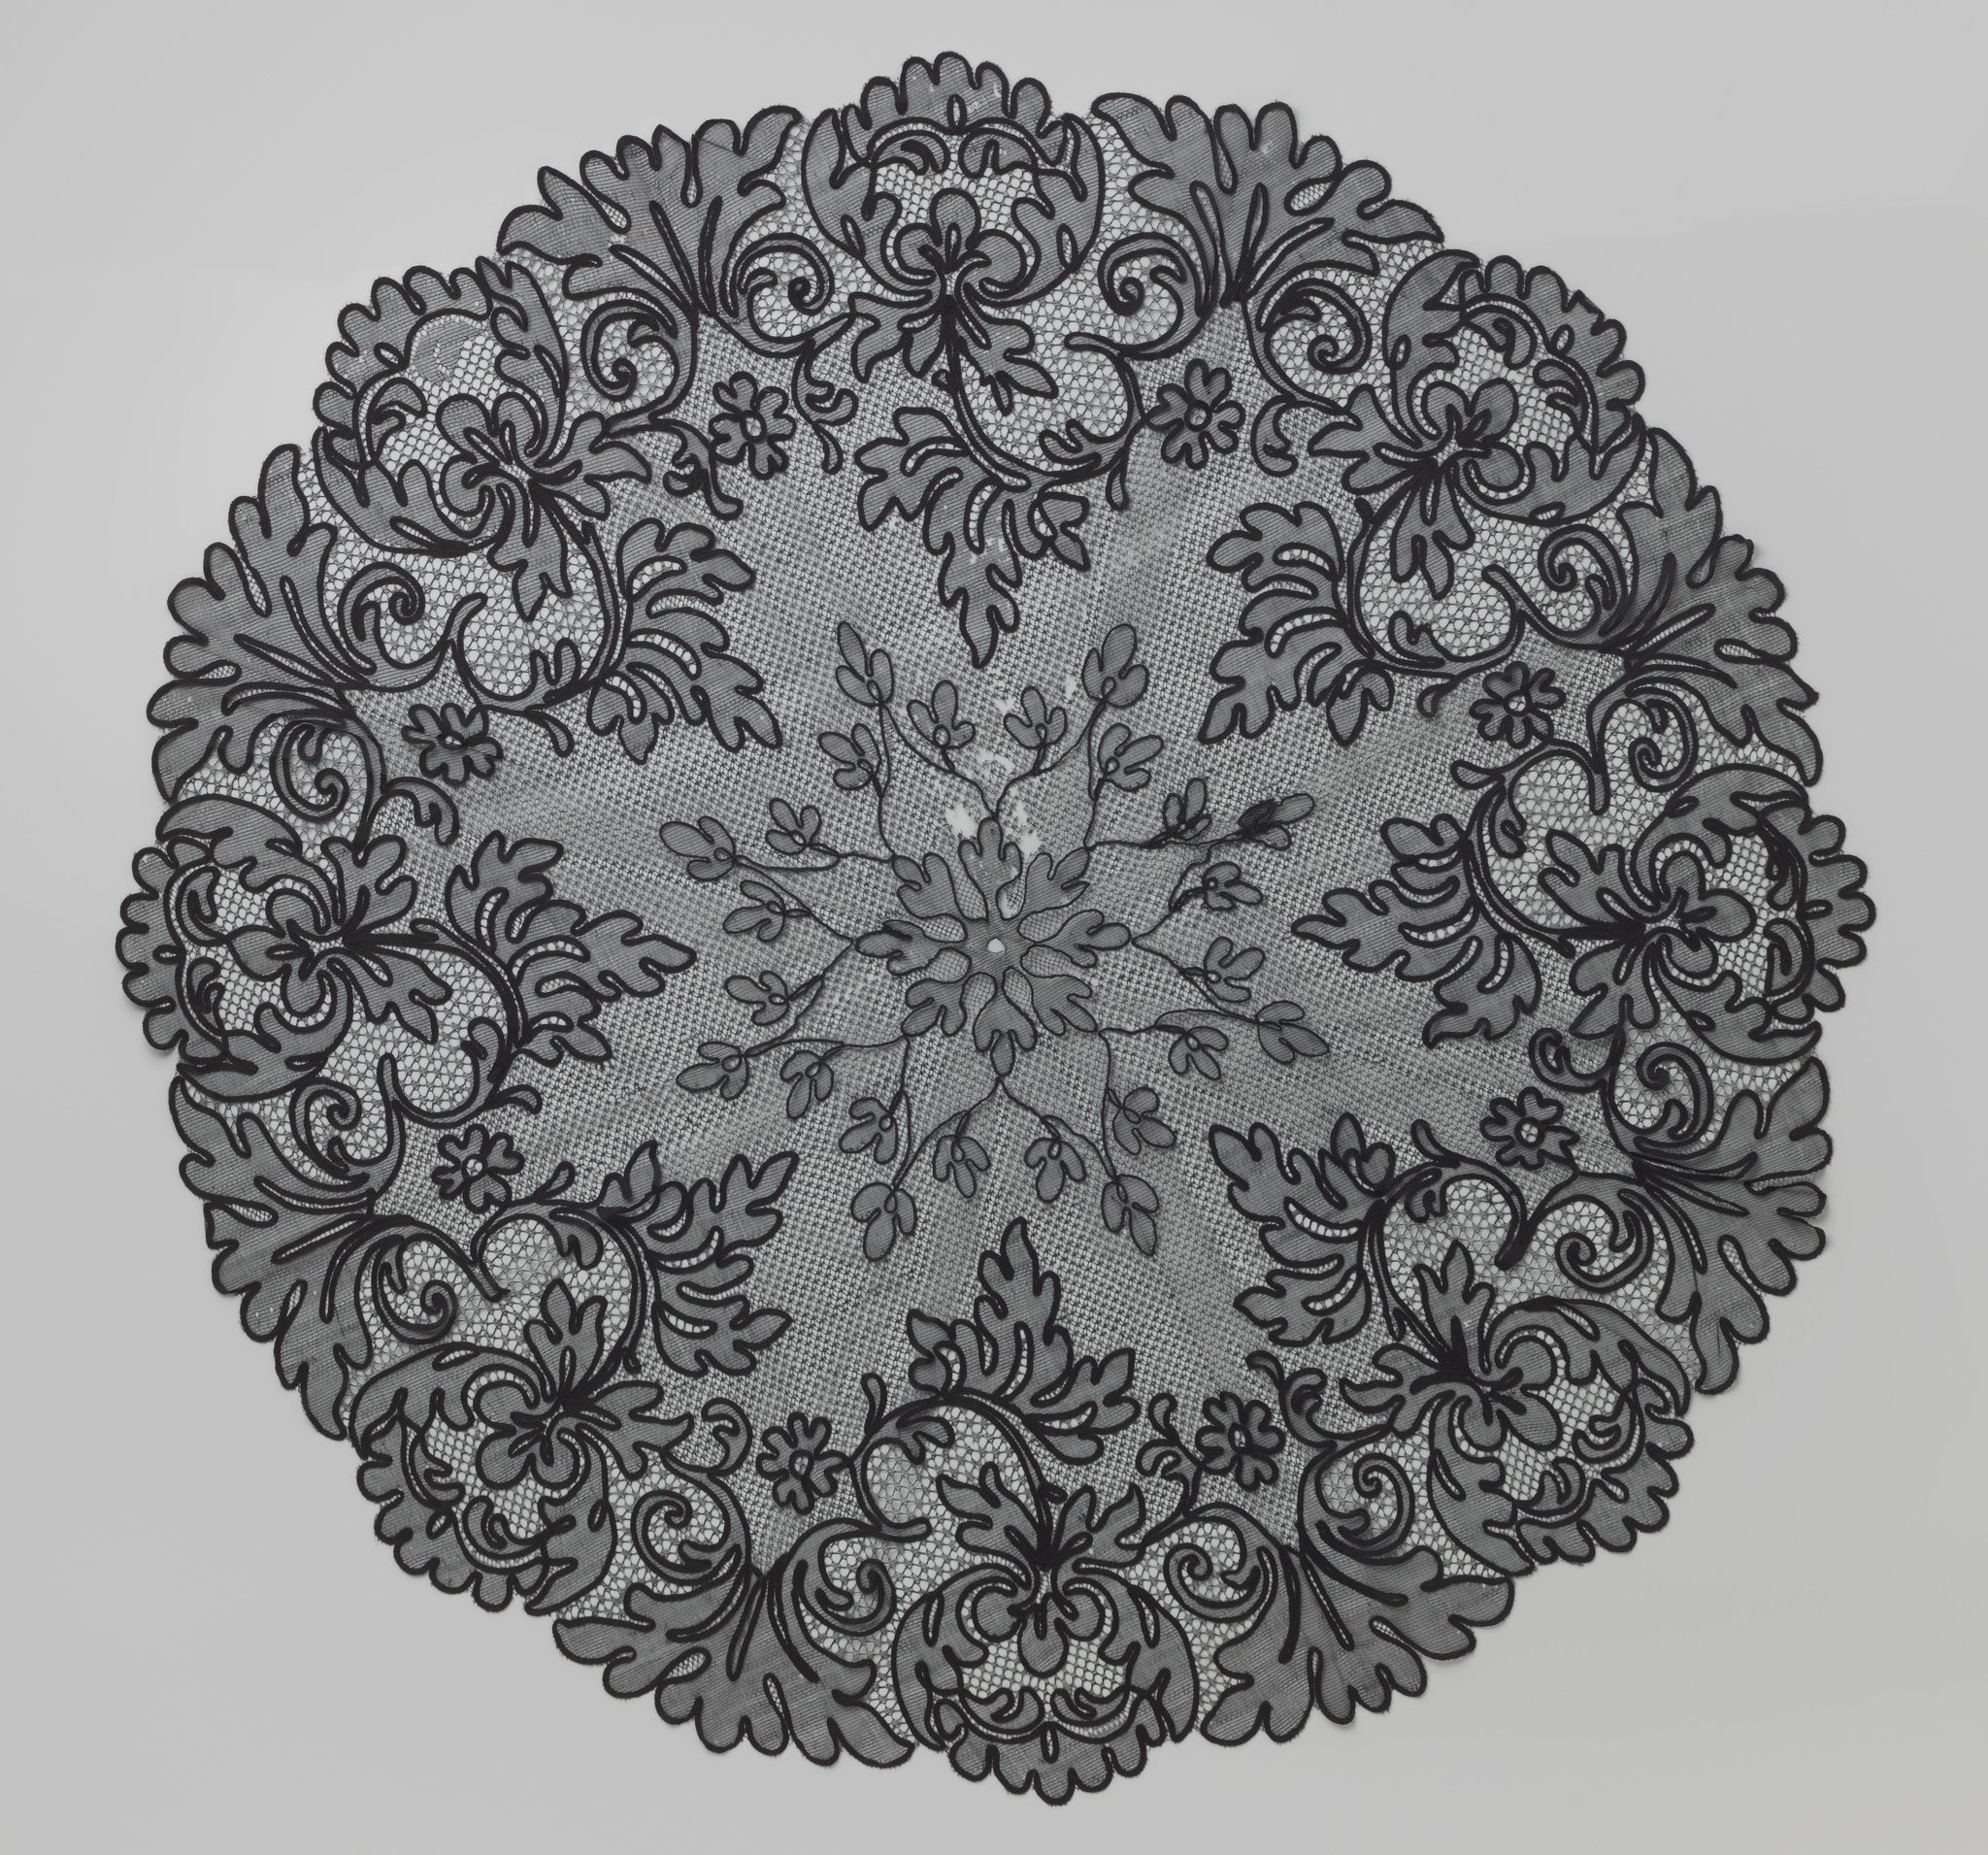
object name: womenswear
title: Parasoldek van zwart veterkant, versierd met een bloem en acht hangende bladpalmetten; de tussenruimtes bestaan uit siersteken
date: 1875-1900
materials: lace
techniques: lace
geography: nijmegen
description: Parasoldek van zwart veterkant. Het dek is rond en heeft een geschulpte rand. Rond het middelpunt van het dek is een bloem geborduurd. De rand bestaat uit acht hangende bladpalmetten. De tussenruimtes bestaan uit siersteken.